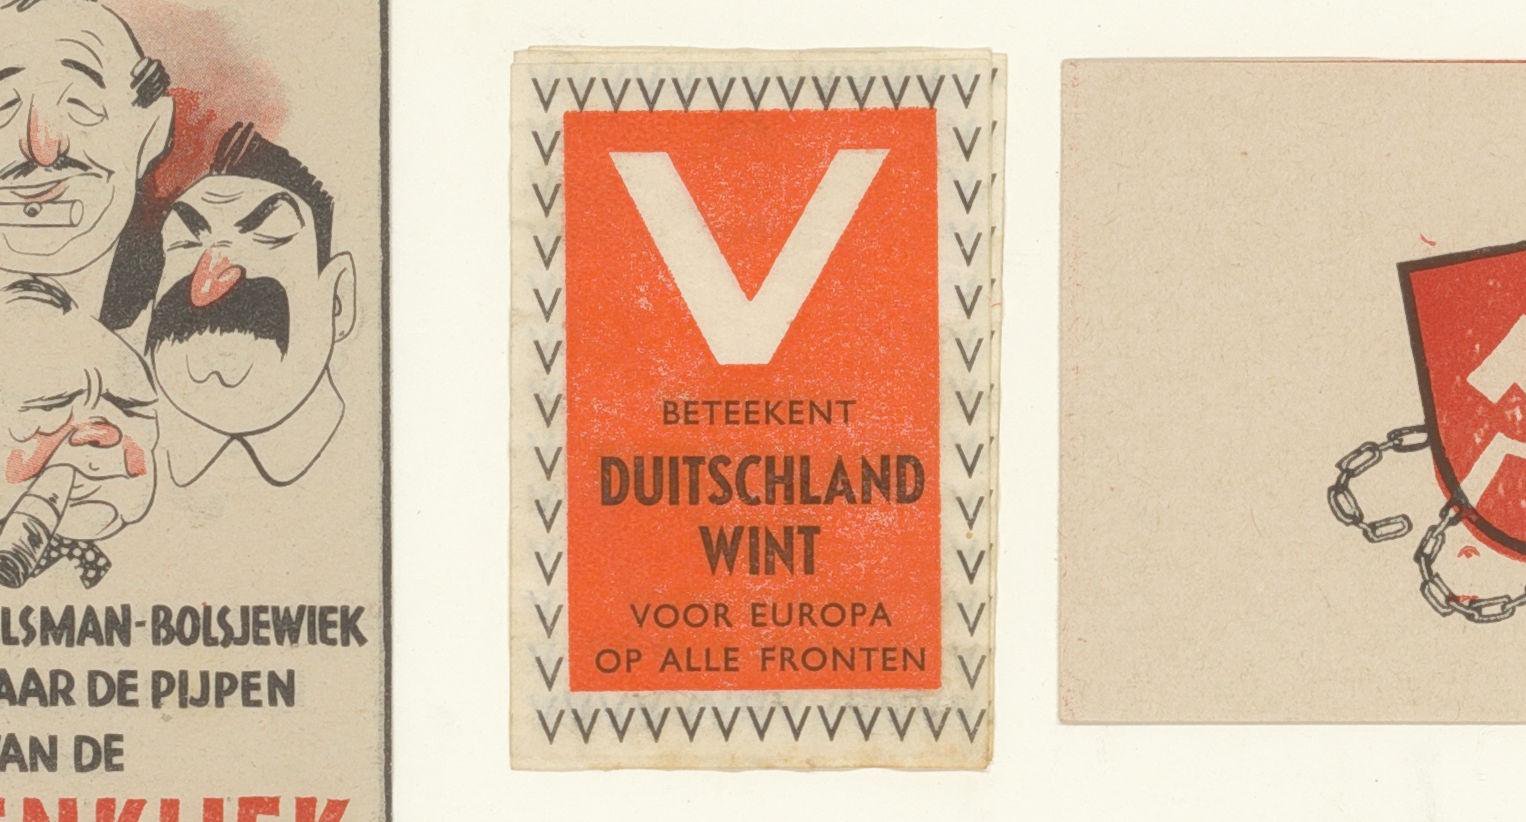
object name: photomechanical print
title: V beteekent Duitschland wint voor Europa op alle fronten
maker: Anonymous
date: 1941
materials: paper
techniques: printing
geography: netherlands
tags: political propaganda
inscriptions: collector's mark: Lugt 1641, collector's mark